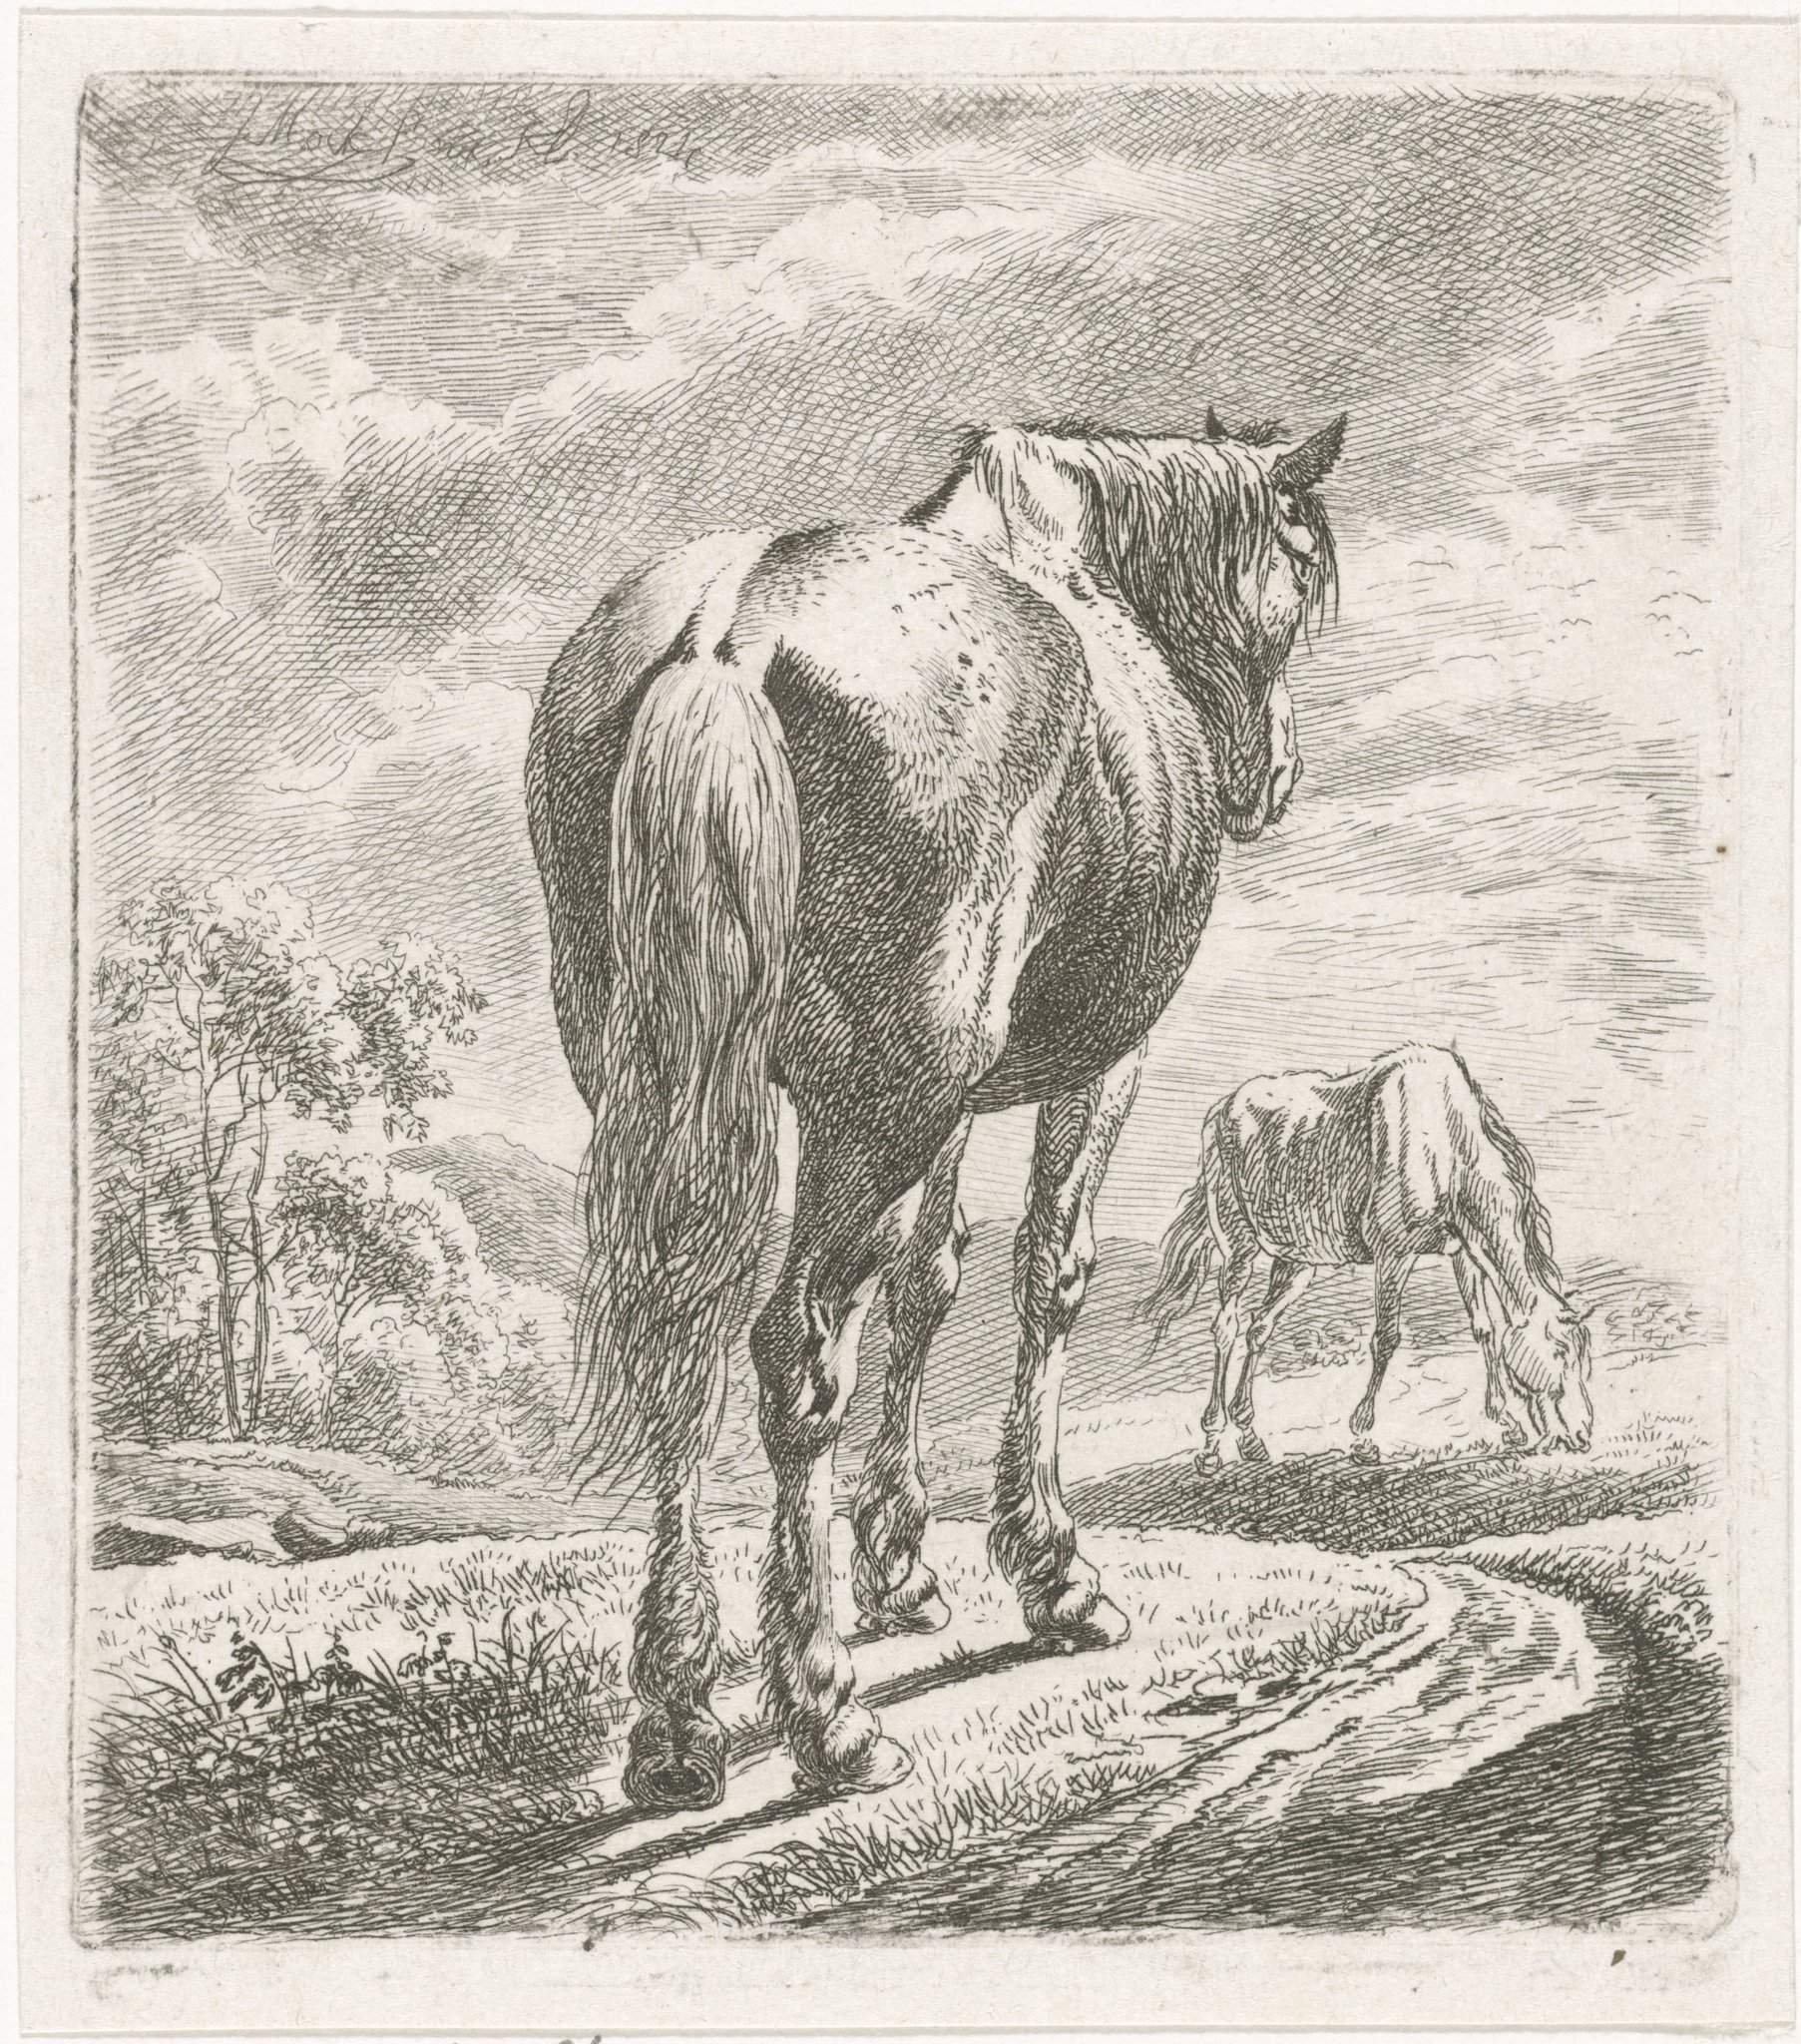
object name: print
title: Paard van achteren gezien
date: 1824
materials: paper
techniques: drypoint, etching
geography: netherlands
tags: horse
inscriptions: collector's mark: Lugt 2228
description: Een paard schuin van achteren gezien. Op de achtergrond een grazend paard.